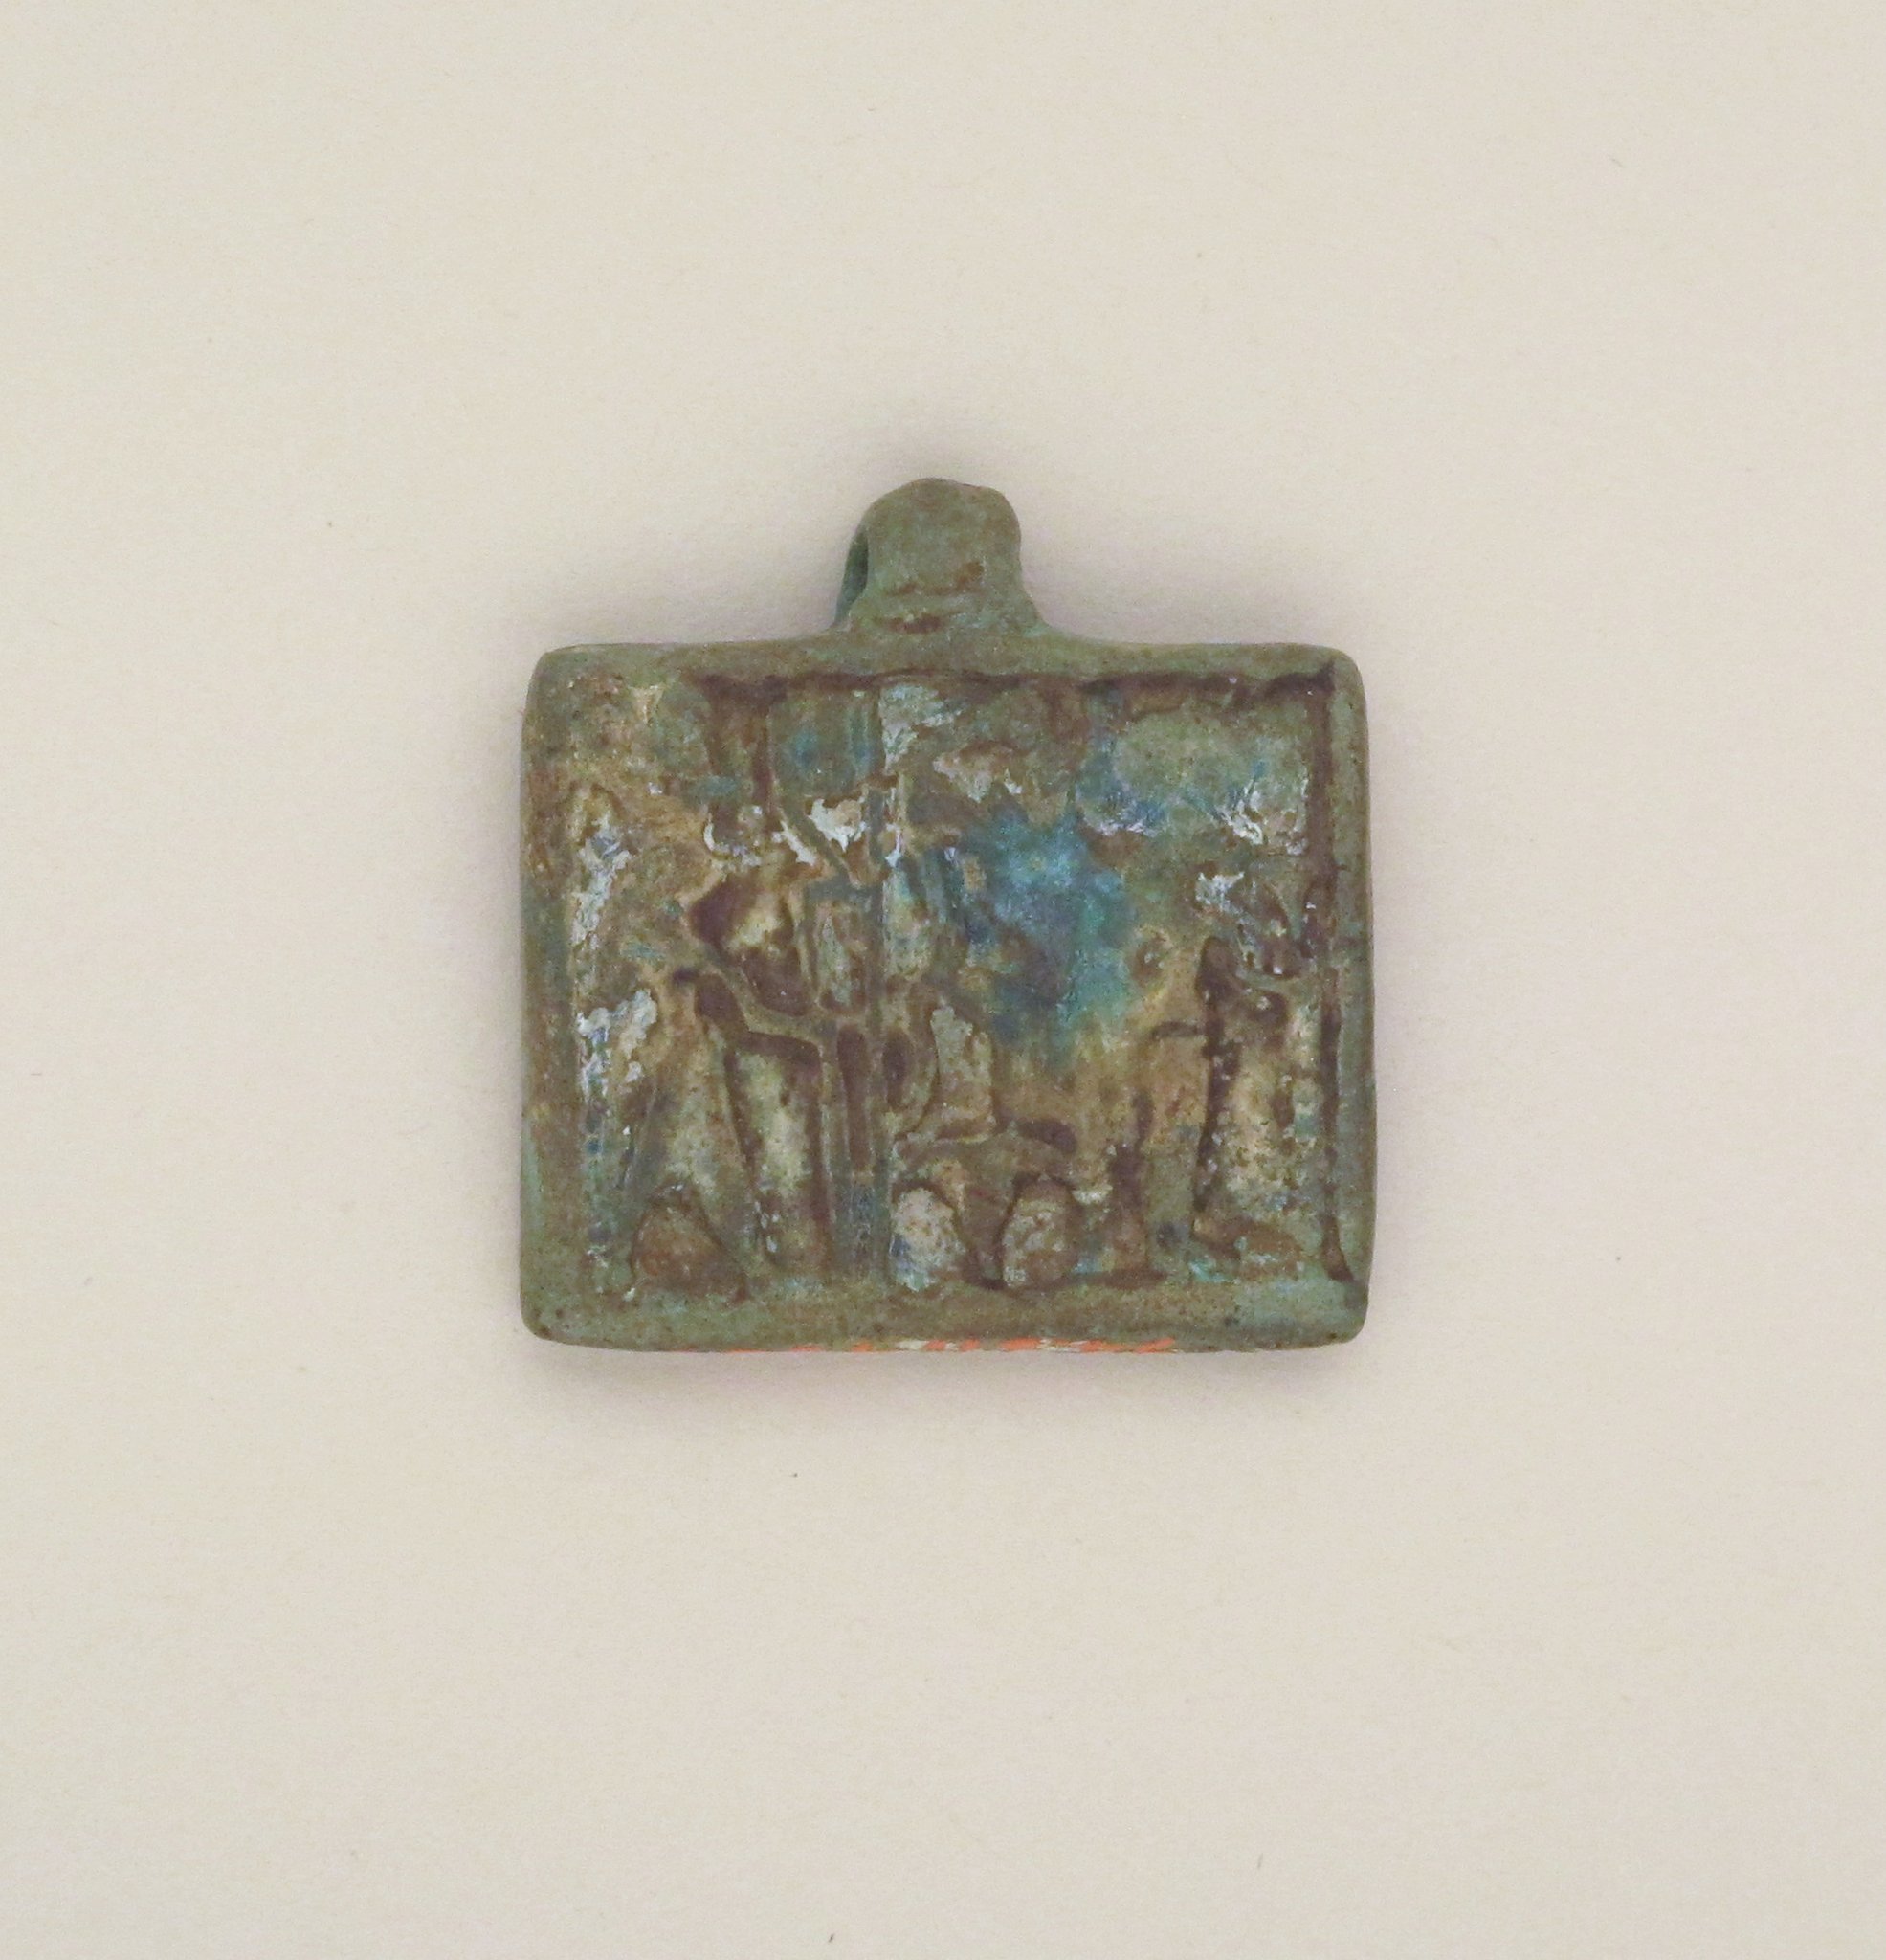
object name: amulet plaque, group of deity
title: Faience amulet plaque with several deities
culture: egyptian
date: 664-630 BCE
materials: faience